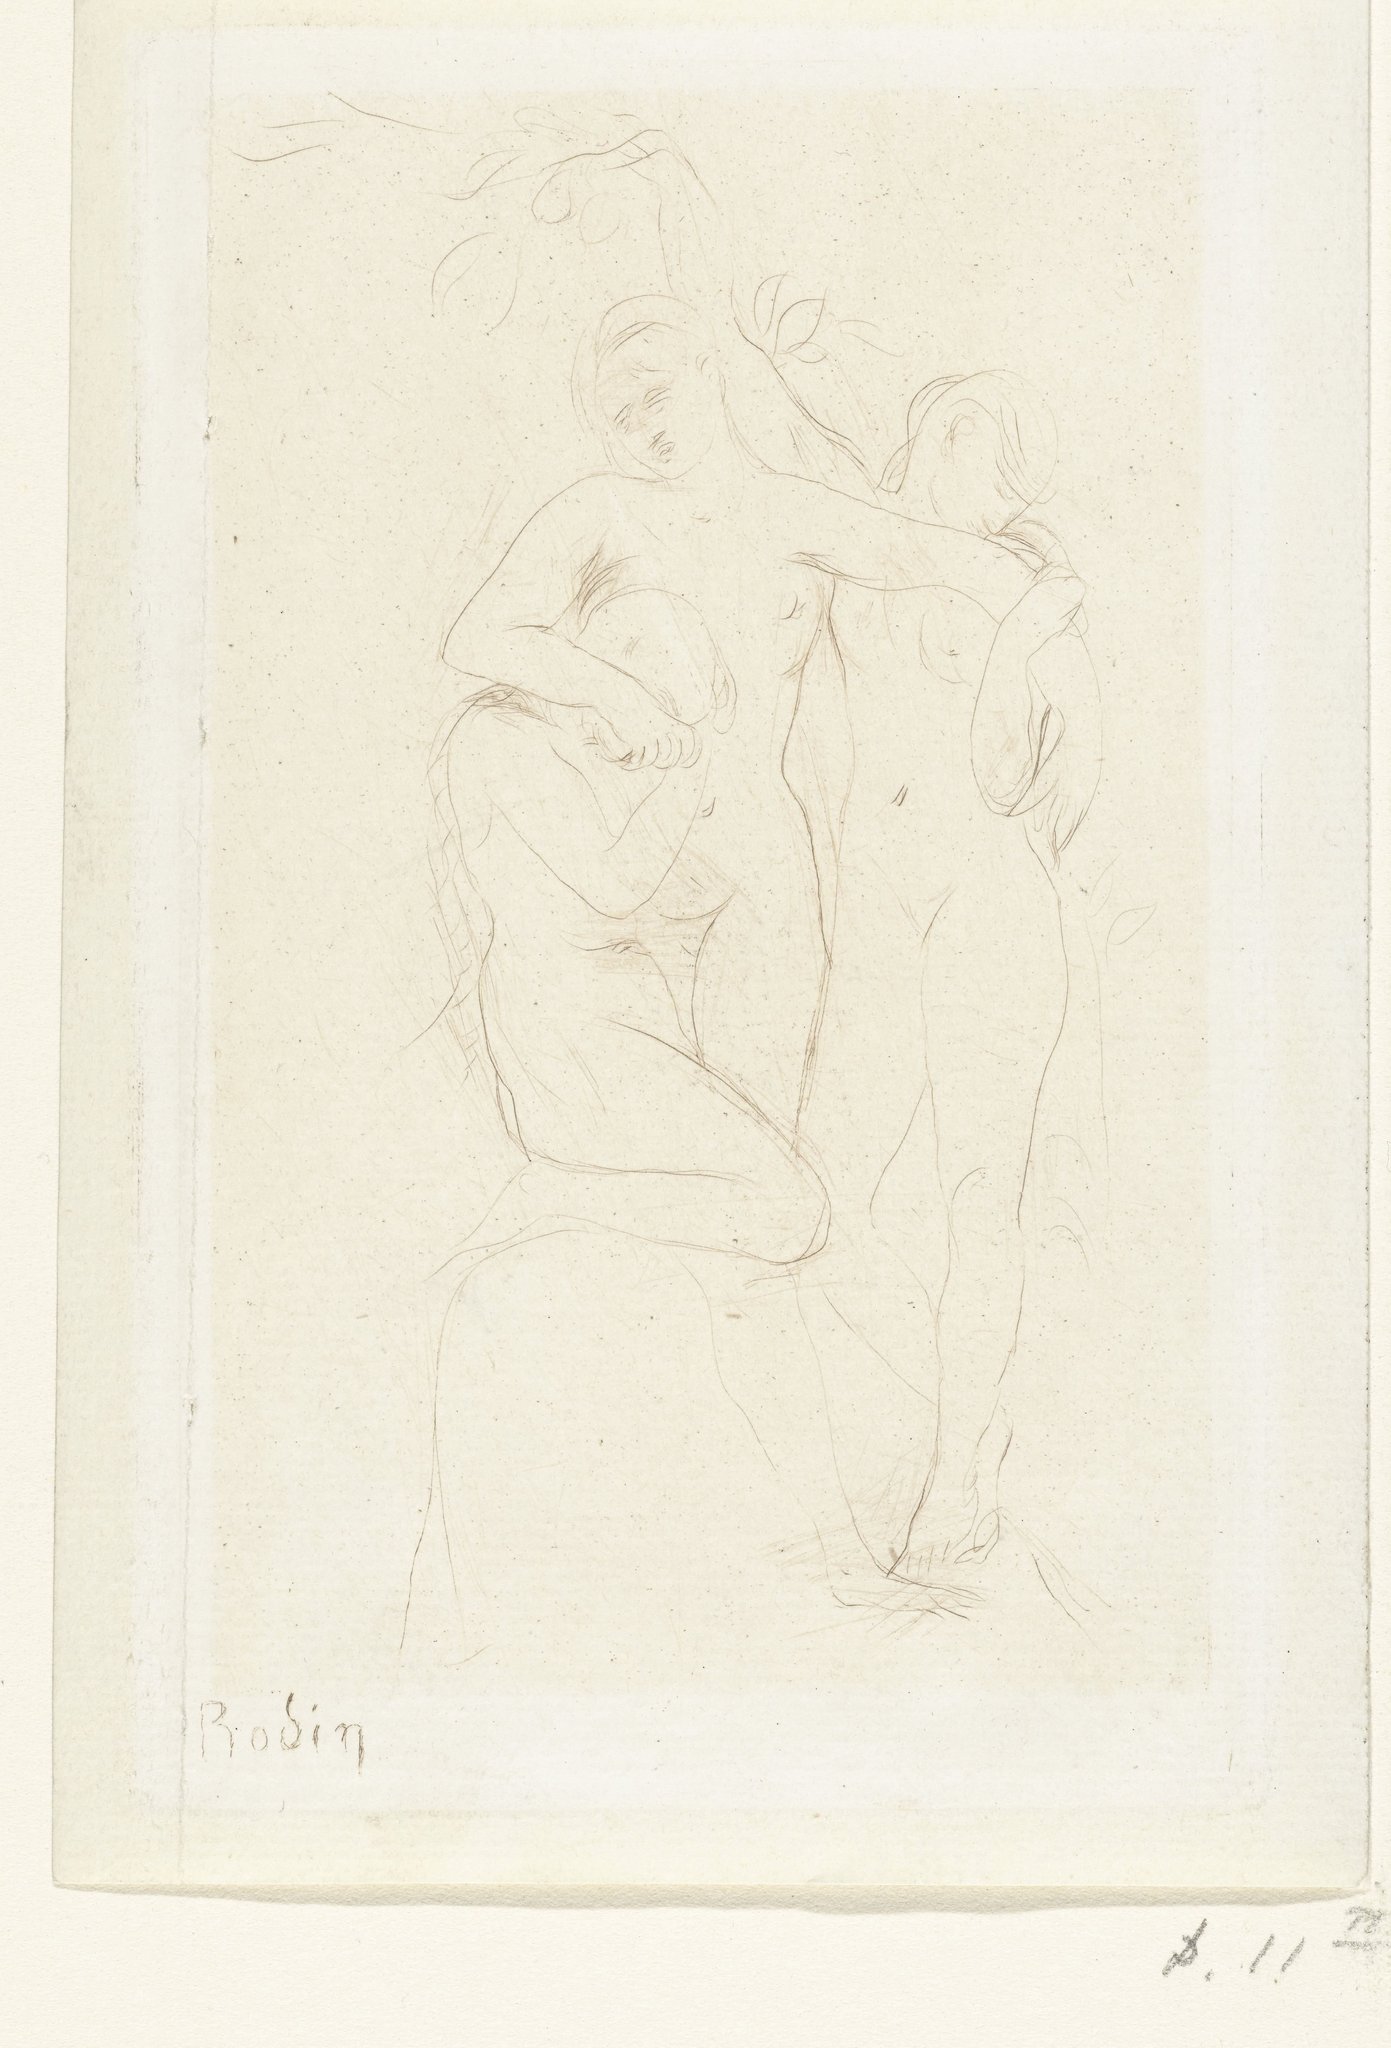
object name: print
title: Zielen in het vagevuur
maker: auguste rodin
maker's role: draughtsman, print maker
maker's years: 1840-1917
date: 1893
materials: paper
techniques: drypoint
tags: hell and purgatory, female sex; woman, the tree of knowledge of good and evil (whose fruit, usually apples or figs, brings death); the tree may be guarded by the serpent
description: Drie vrouwen met hun armen in omstrengeling staan en zitten onder een boom. Deze boom wordt gezien als de boom van kennis van goed en kwaad waaronder de vrouwen treuren over hun zonden en steun zoeken bij elkaar. Zij bevinden zich in het vagevuur.